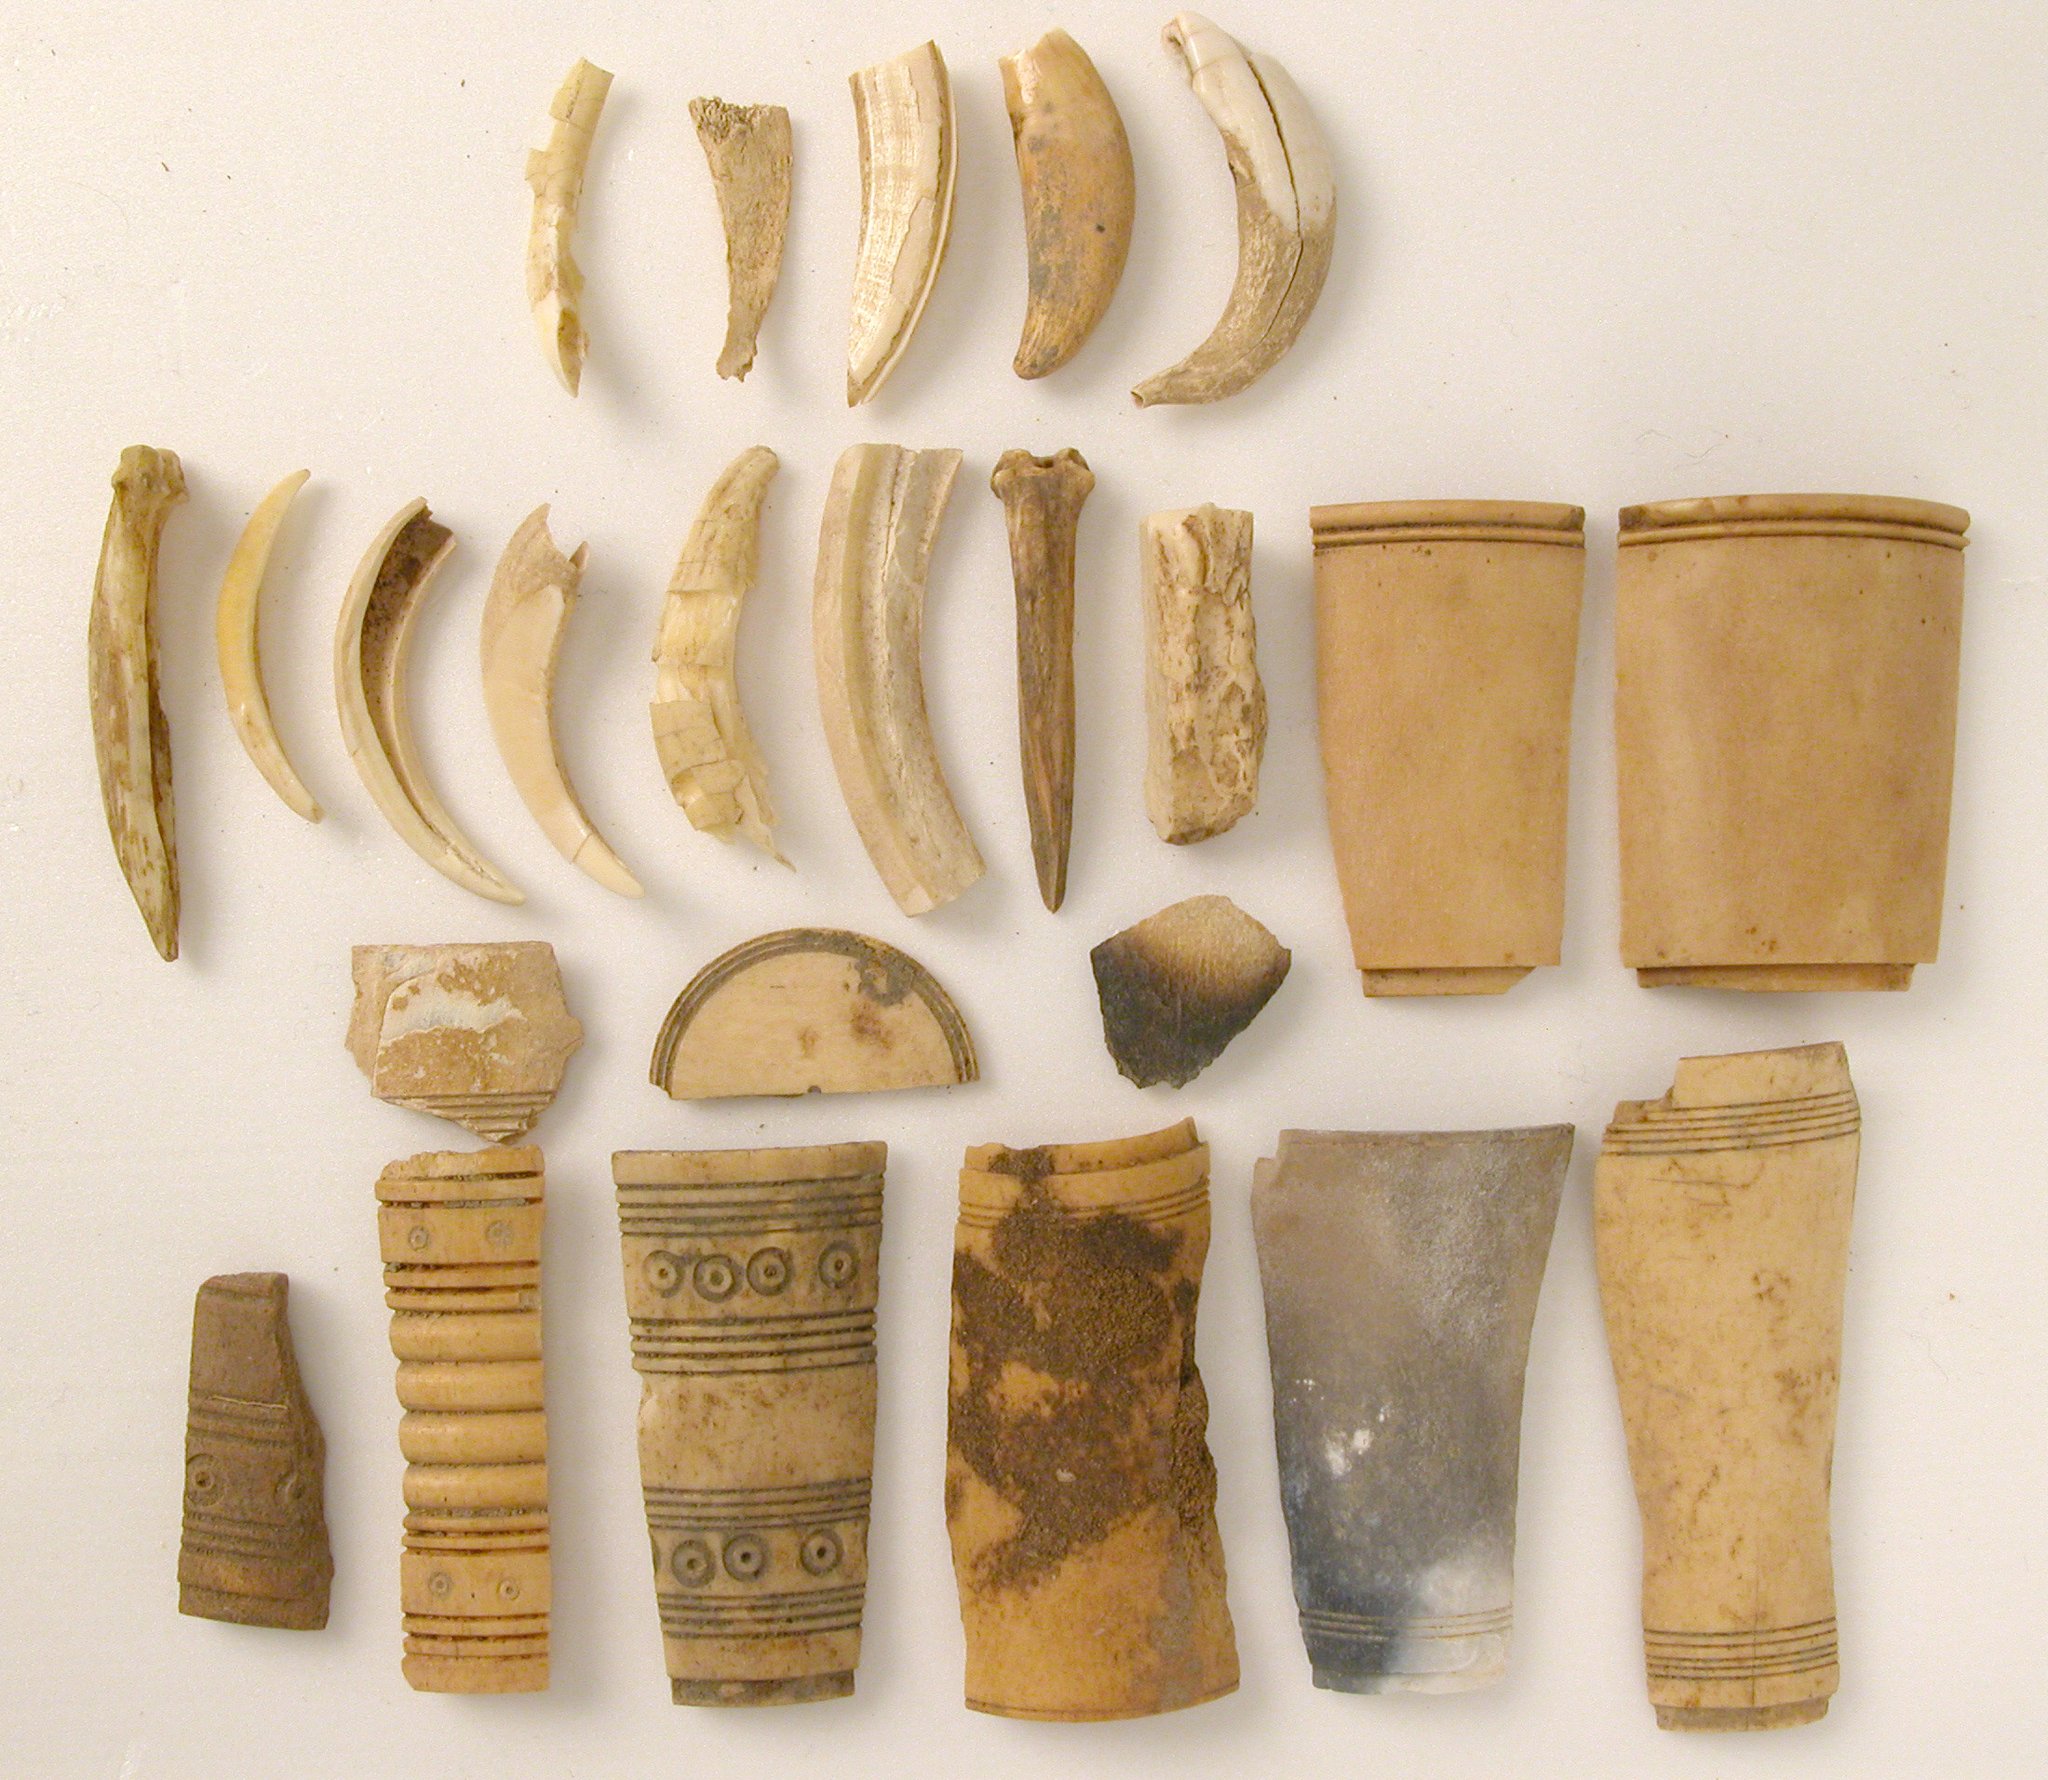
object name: fragment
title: Bone Fragments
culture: coptic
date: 301-700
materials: bone, stone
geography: egypt